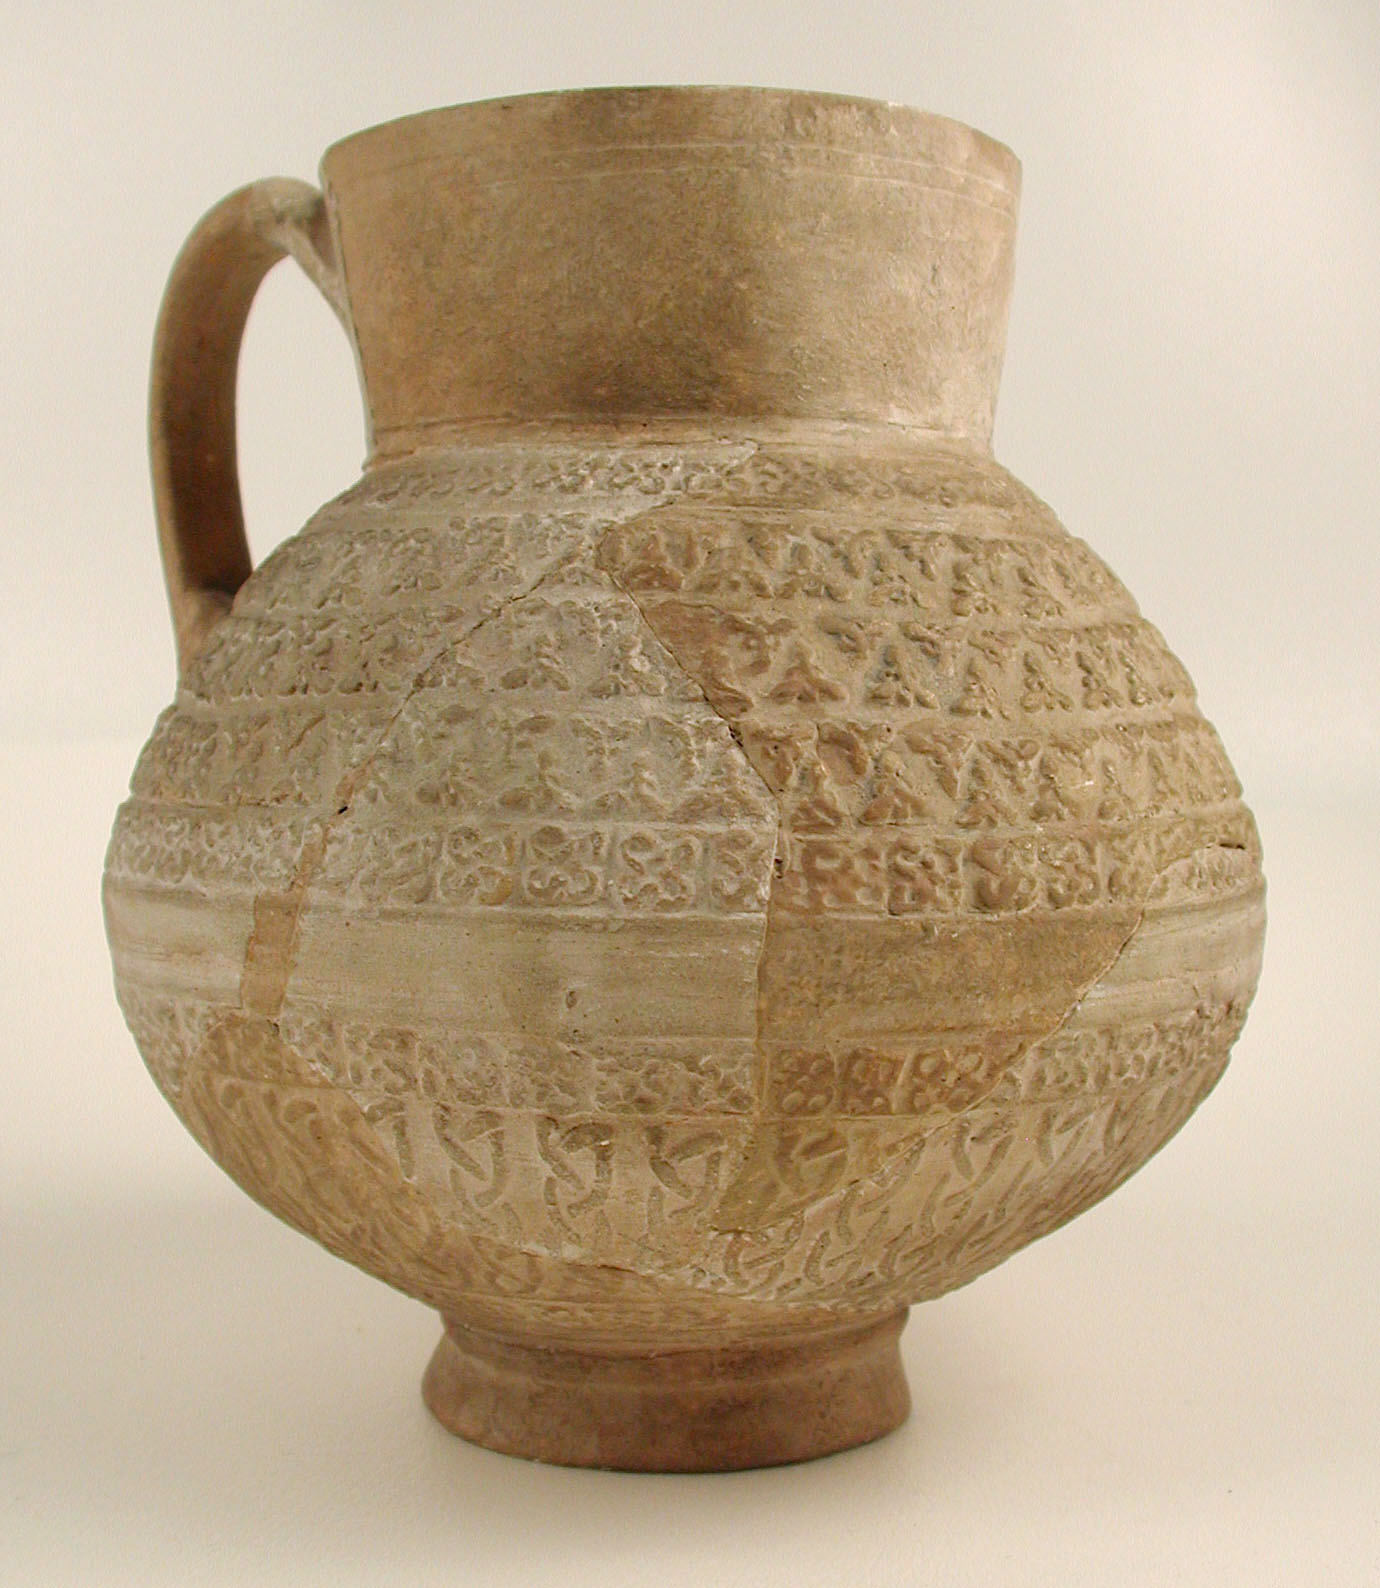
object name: ewer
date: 1101-1300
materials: earthenware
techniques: molding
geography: iran